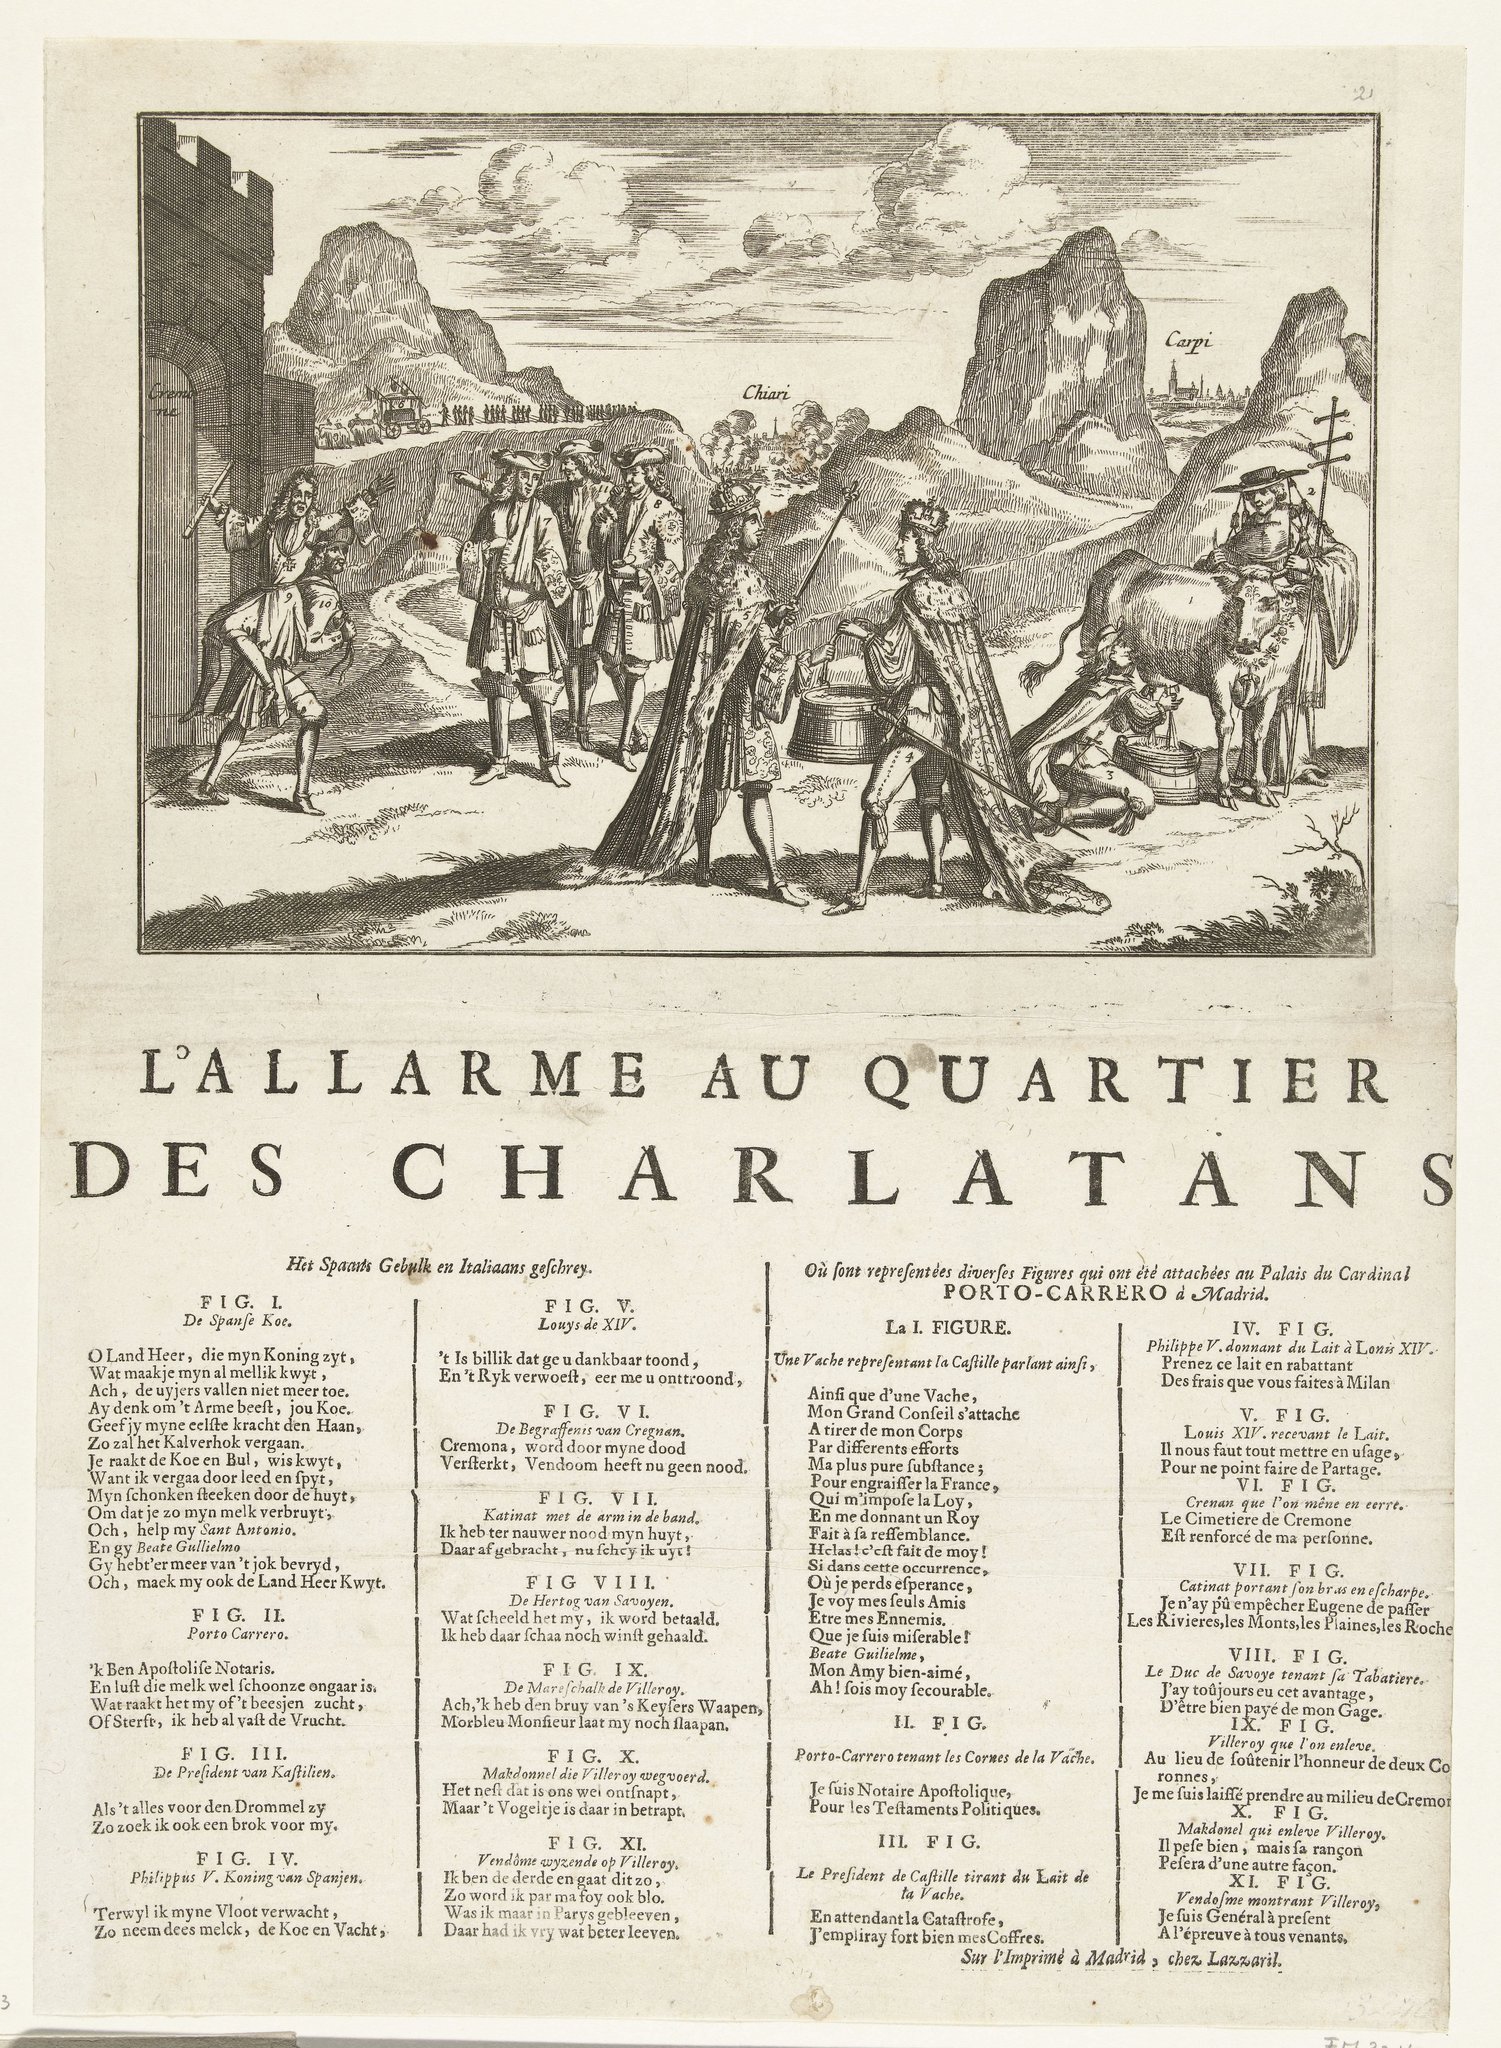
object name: cartoon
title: L'Allarme au Quartier des Charlatans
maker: Anonymous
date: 1701-1702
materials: paper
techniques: engraving, etching, letterpress printing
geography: northern netherlands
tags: lodewijk xiv (koning van frankrijk), filips v (koning van spanje), milking, political caricatures and satires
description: Allegorie waarin de kardinaal Portocarrero de Spaanse koe laat melken door de president van Castilië, Filips V geeft de melk aan Lodewijk XIV. Op het blad onder de plaat verzen in het Nederlands en Frans. Onderdeel van een groep afzonderlijke spotprenten op Lodewijk XIV tijdens de Spaanse Successieoorlog, ca. 1701-1713.